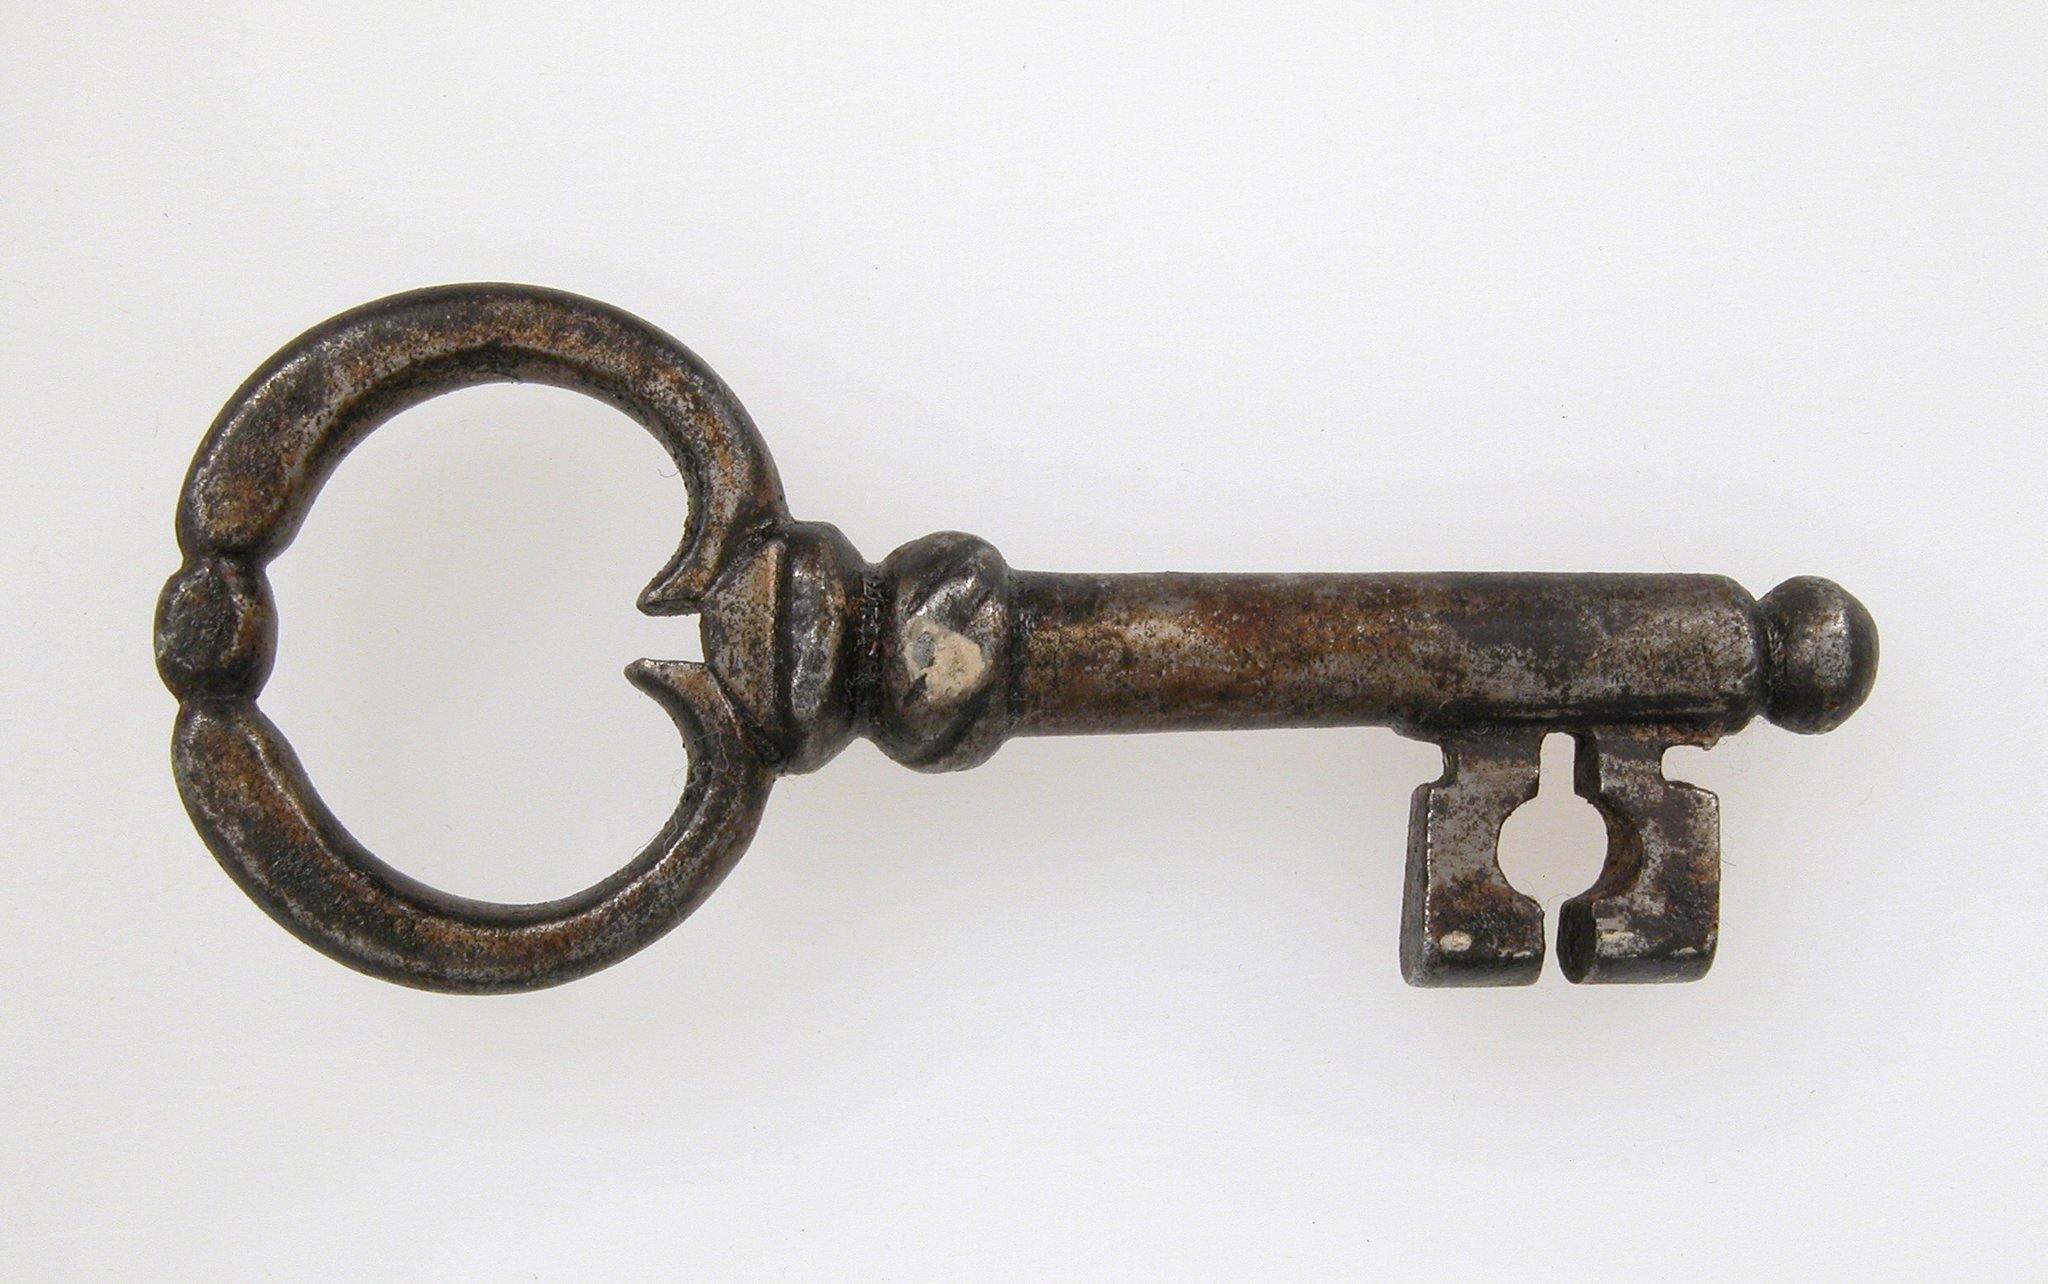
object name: key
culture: german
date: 1401-1500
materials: iron